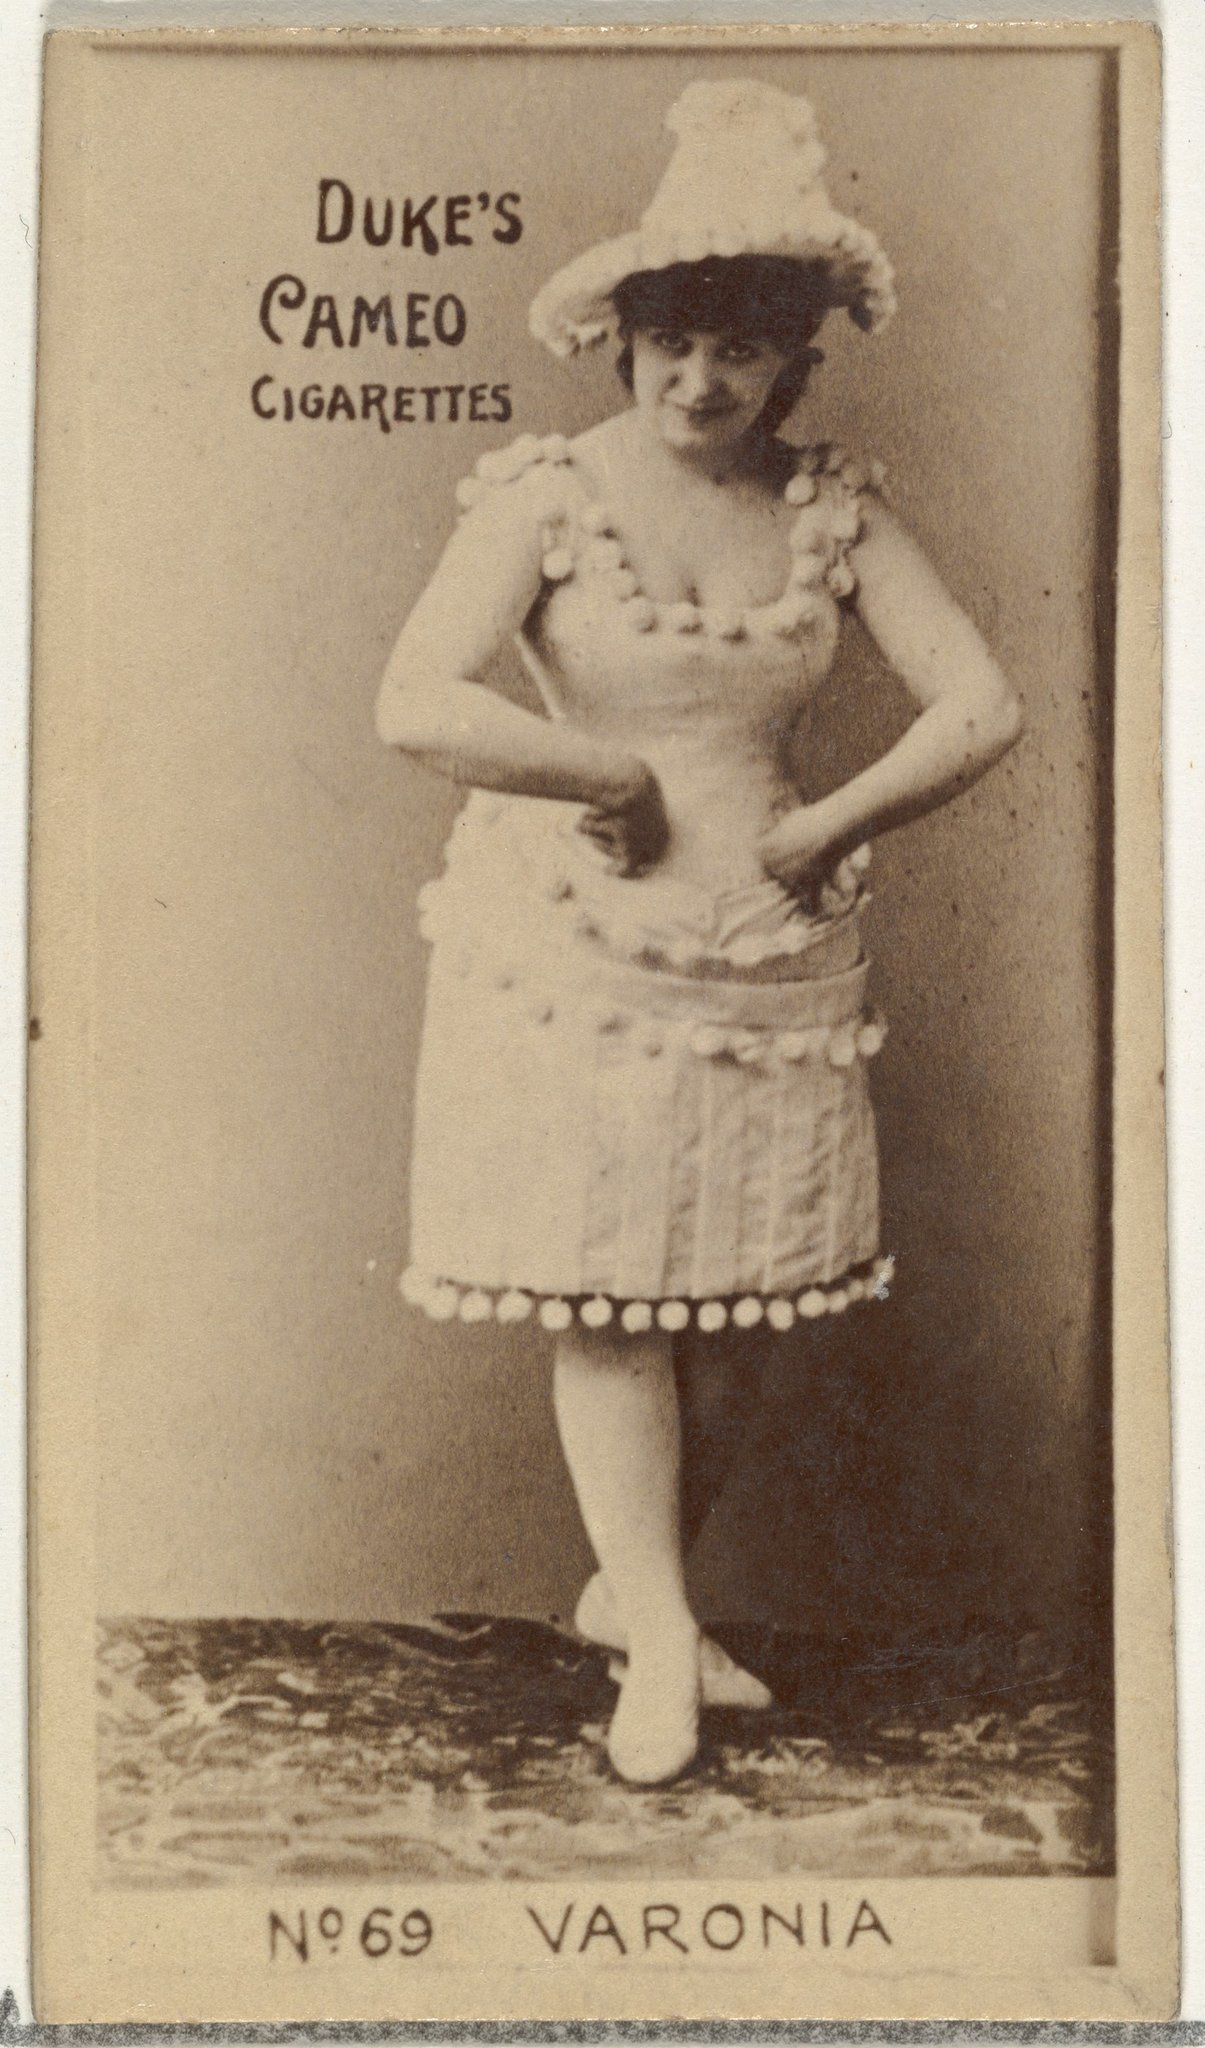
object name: photograph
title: Card Number 69, Irene Varonia, from the Actors and Actresses series (N145-4) issued by Duke Sons & Co. to promote Cameo Cigarettes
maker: w. duke, sons & co.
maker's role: publisher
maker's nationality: american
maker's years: 1870-1920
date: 1880-1889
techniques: albumen silver print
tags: portraits,women,actresses